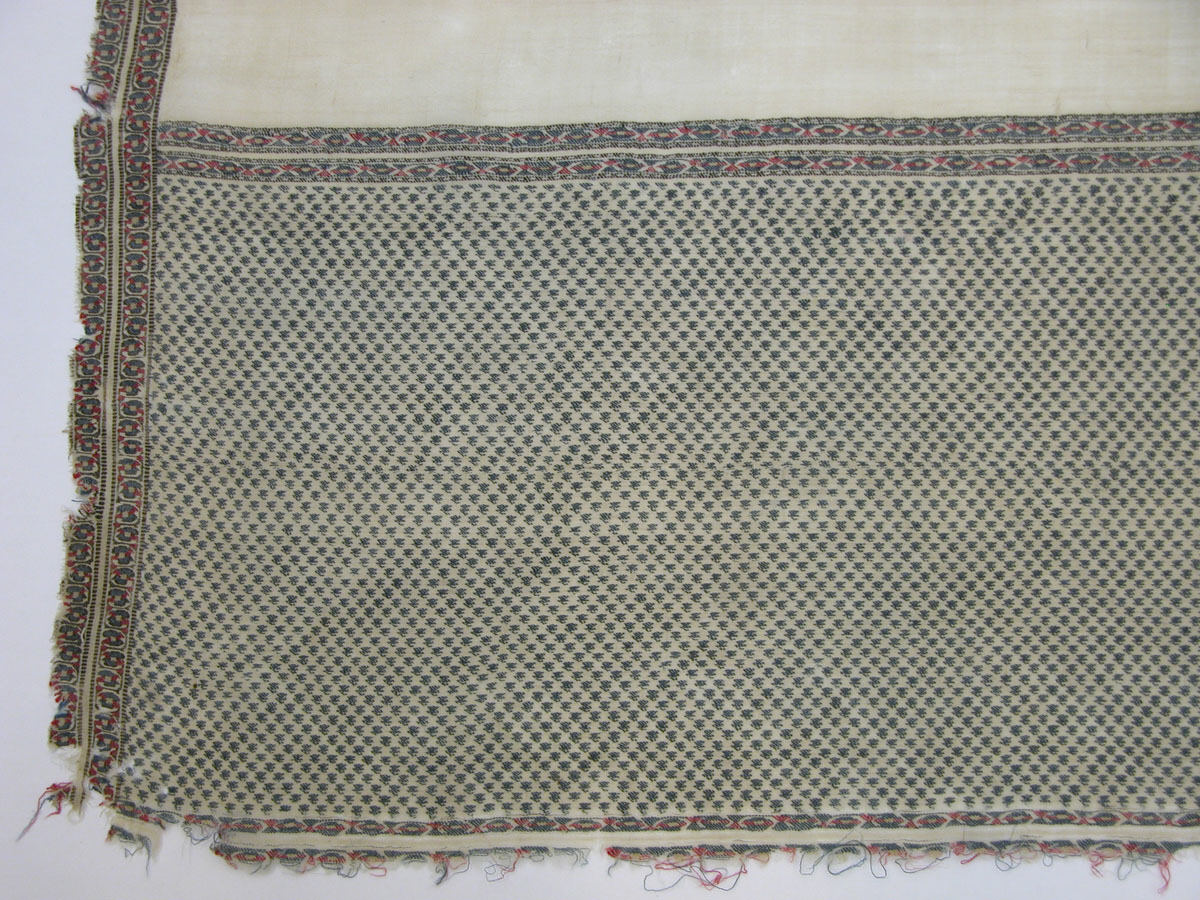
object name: shawl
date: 1790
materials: wool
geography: india